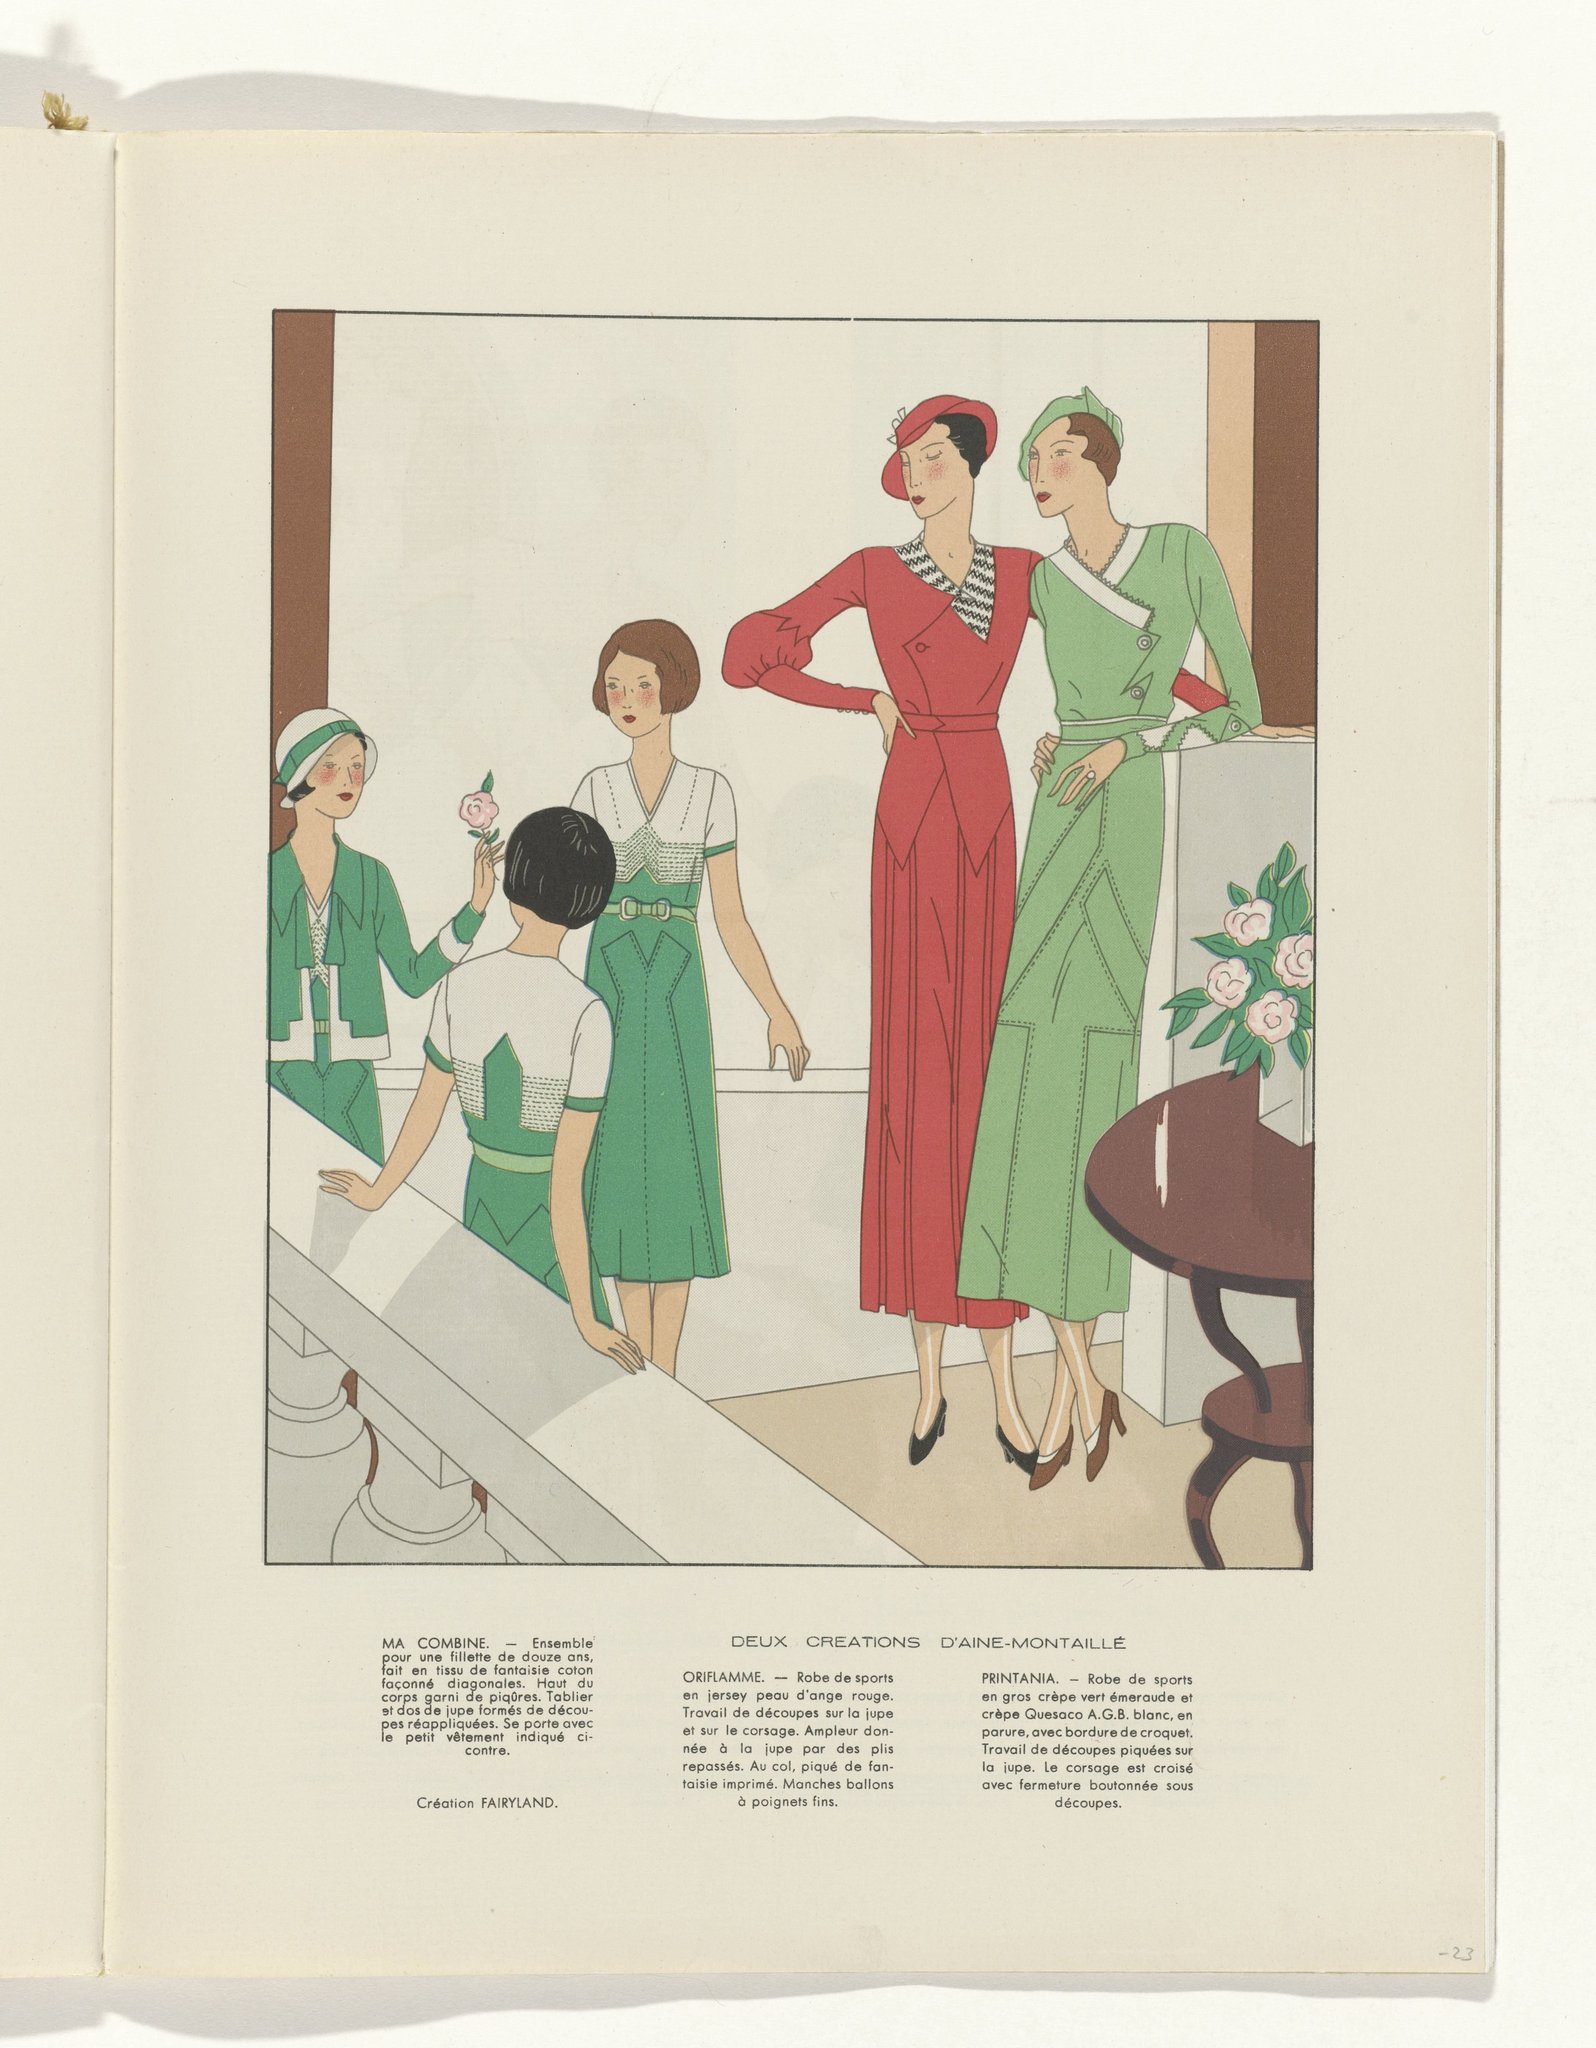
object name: magazine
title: Art - Goût - Beauté, Feuillets de l' élégance féminine, Juin 1932, No. 142, 12e Année, p. 23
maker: henri rouit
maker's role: publisher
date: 1932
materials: paper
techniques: hand coloring, lithograph, photography, pochoir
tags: dress, gown (robe de sport) (+ women's clothes), fashion plates, head-gear: hat (+ women's clothes), dress, gown (+ girls' clothes)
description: Twee creaties van D'Aine-Montaillé en kinderkleding van Fairyland. Pagina uit het modetijdschrift Art-Goût-Beauté (1920-1933).